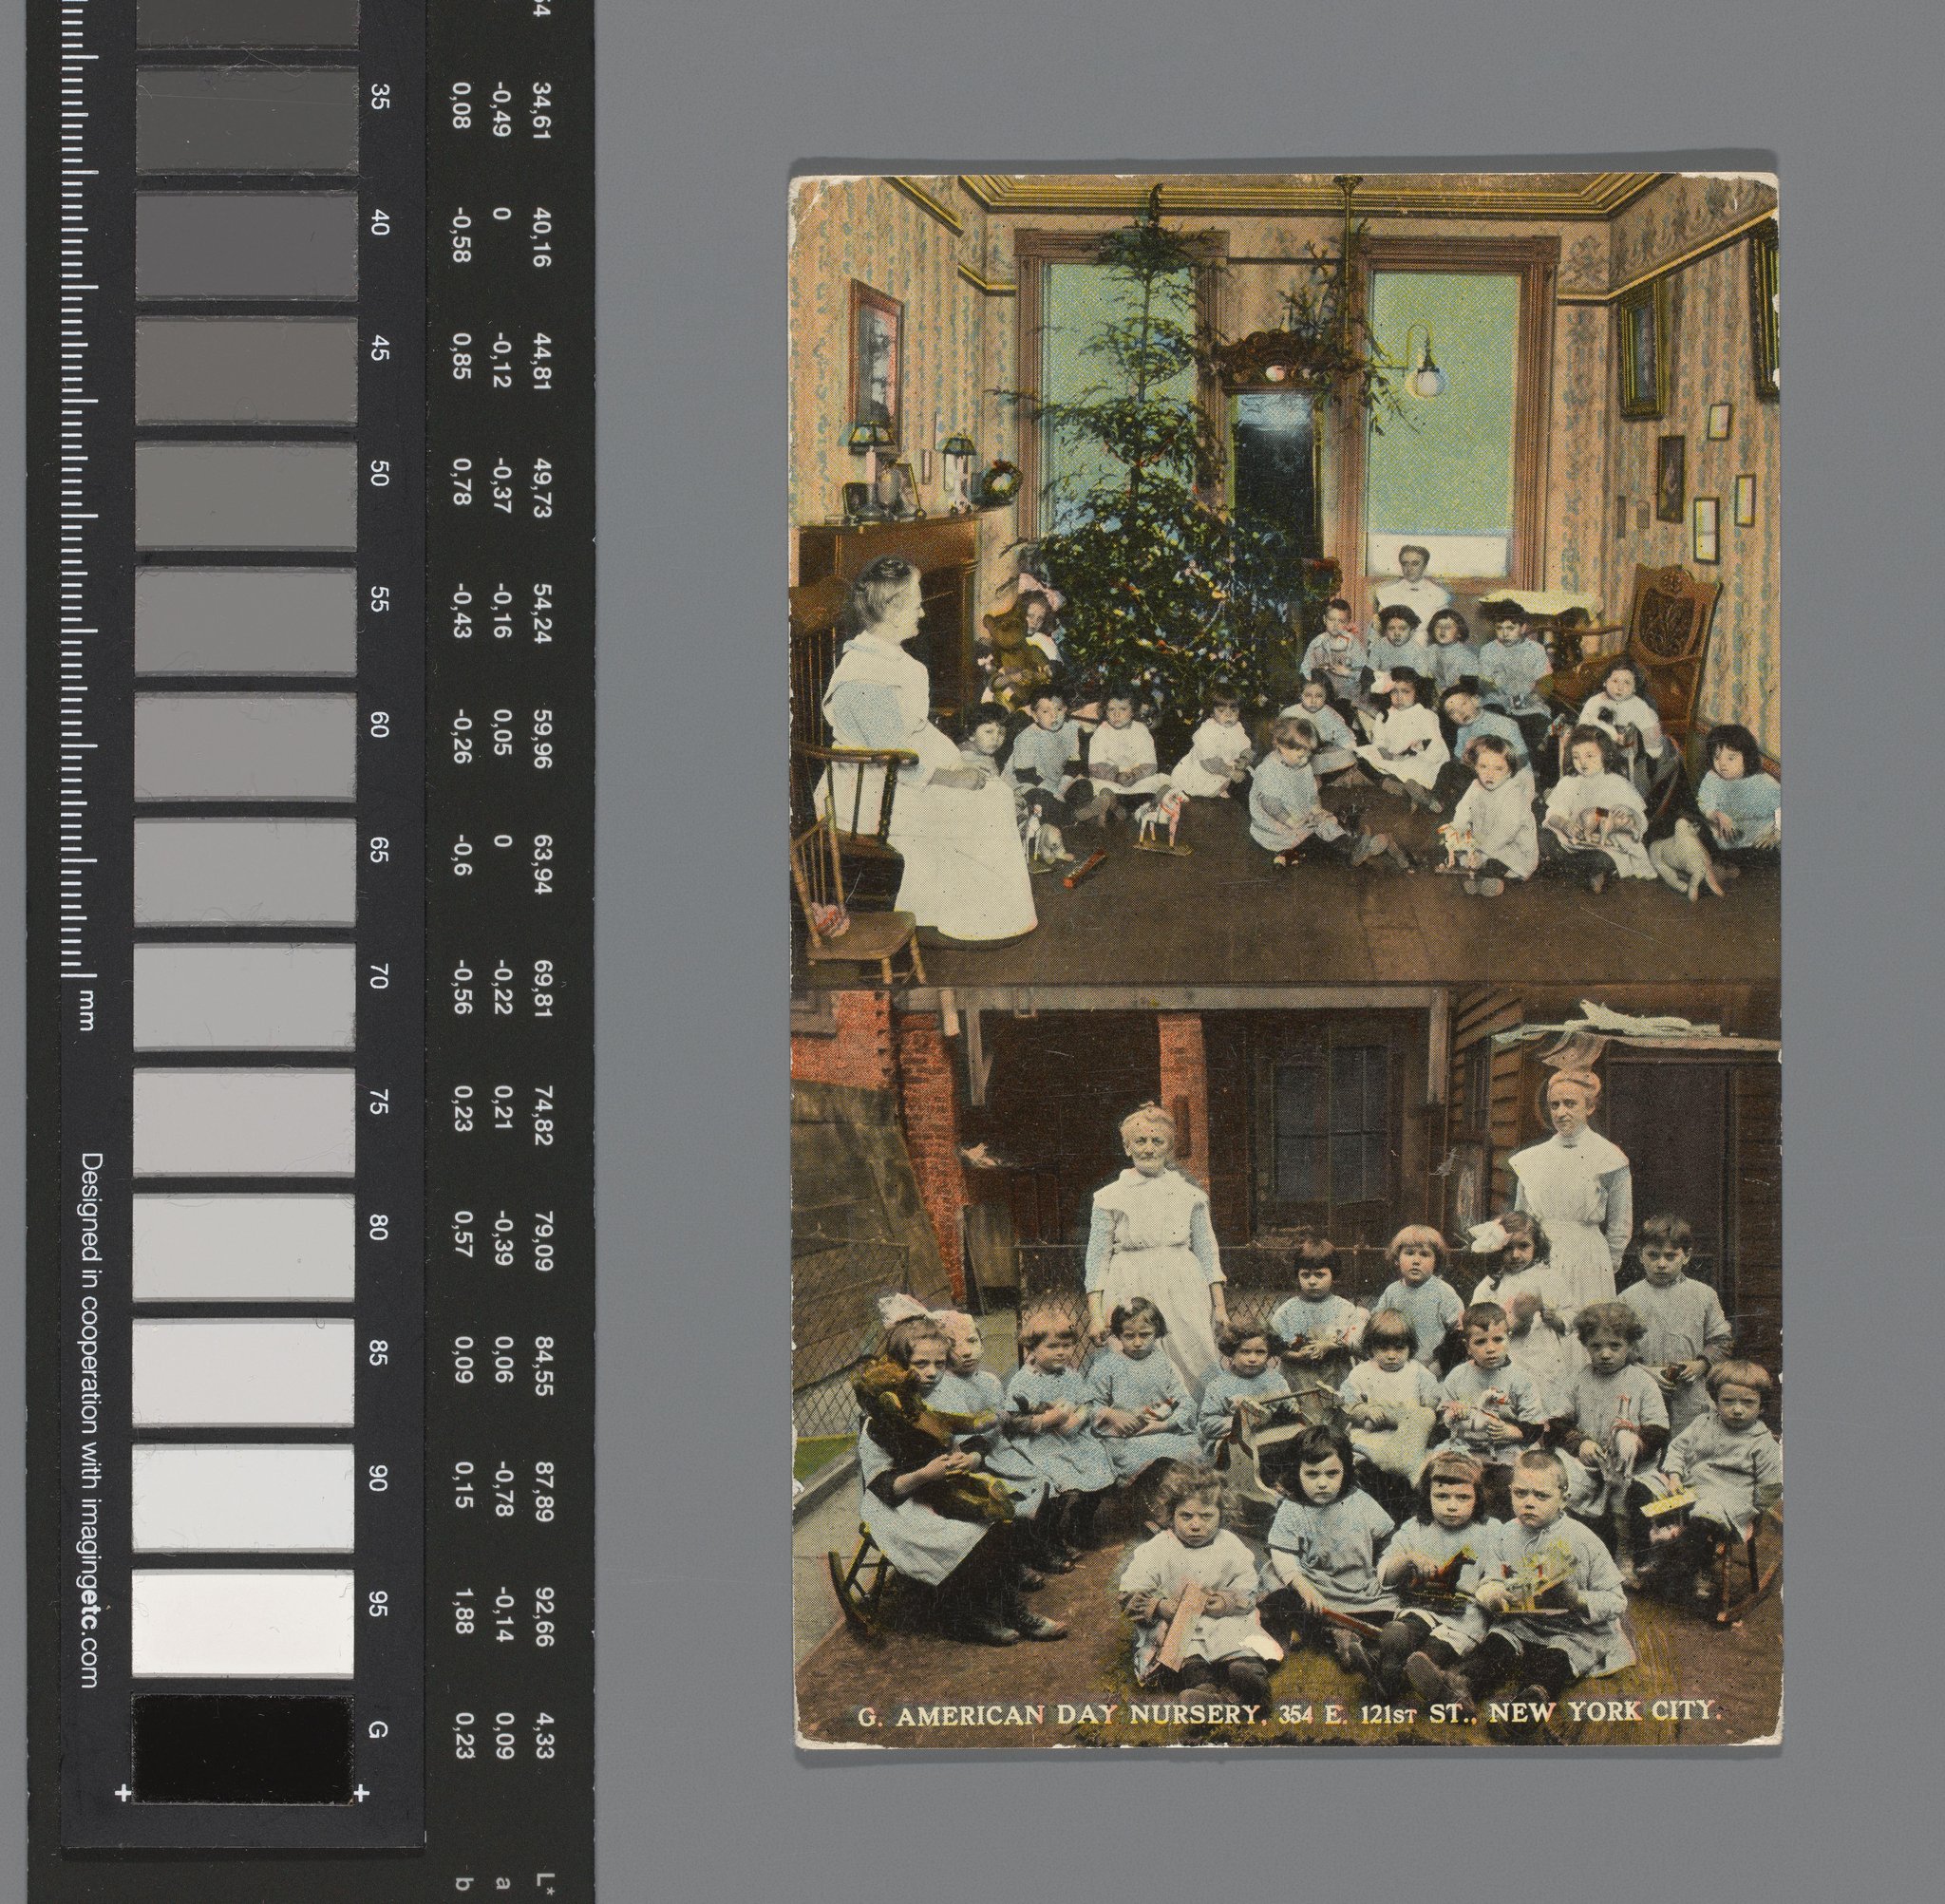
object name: ansichtkaart, prentbriefkaart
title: Prentbriefkaart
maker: Anonymous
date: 1910-1940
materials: paper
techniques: lithograph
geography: united states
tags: new york (city)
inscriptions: title: ‘G[erman] AMERICAN DAY NURSERY [...]’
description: Prentbriefkaart met twee foto’s van kinderen in een kinderdagverblijf in New York.